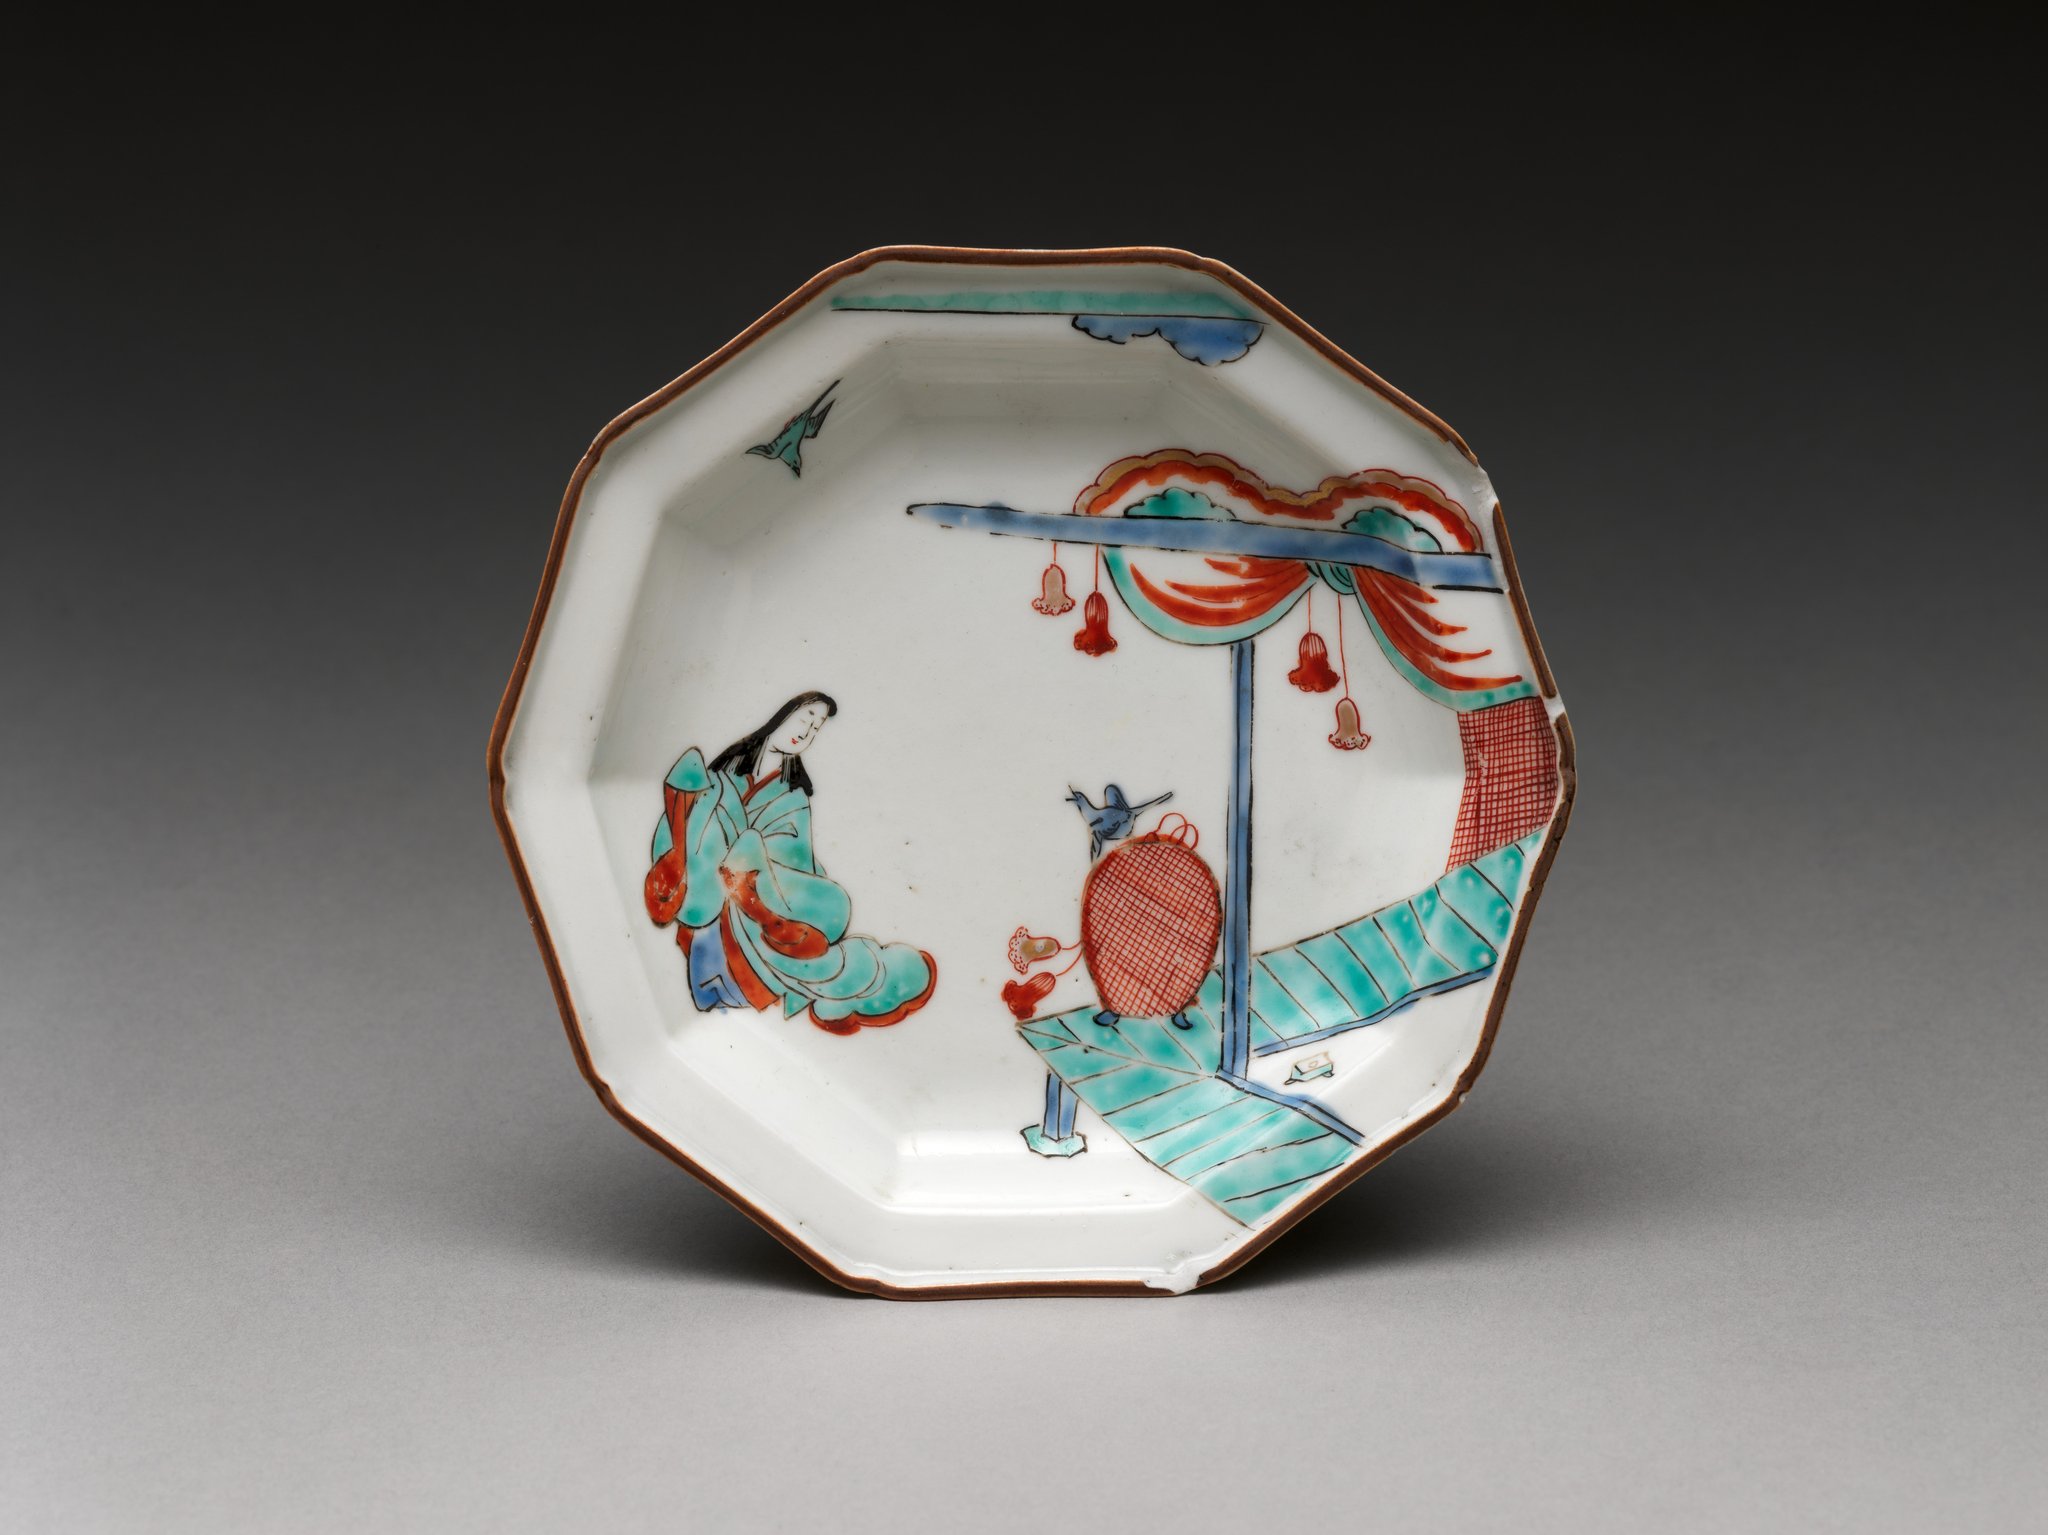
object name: plate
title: Plate with Japanese court woman and birds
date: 1710-1730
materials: enamel, glaze, hard paste porcelain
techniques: painting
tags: birds,women